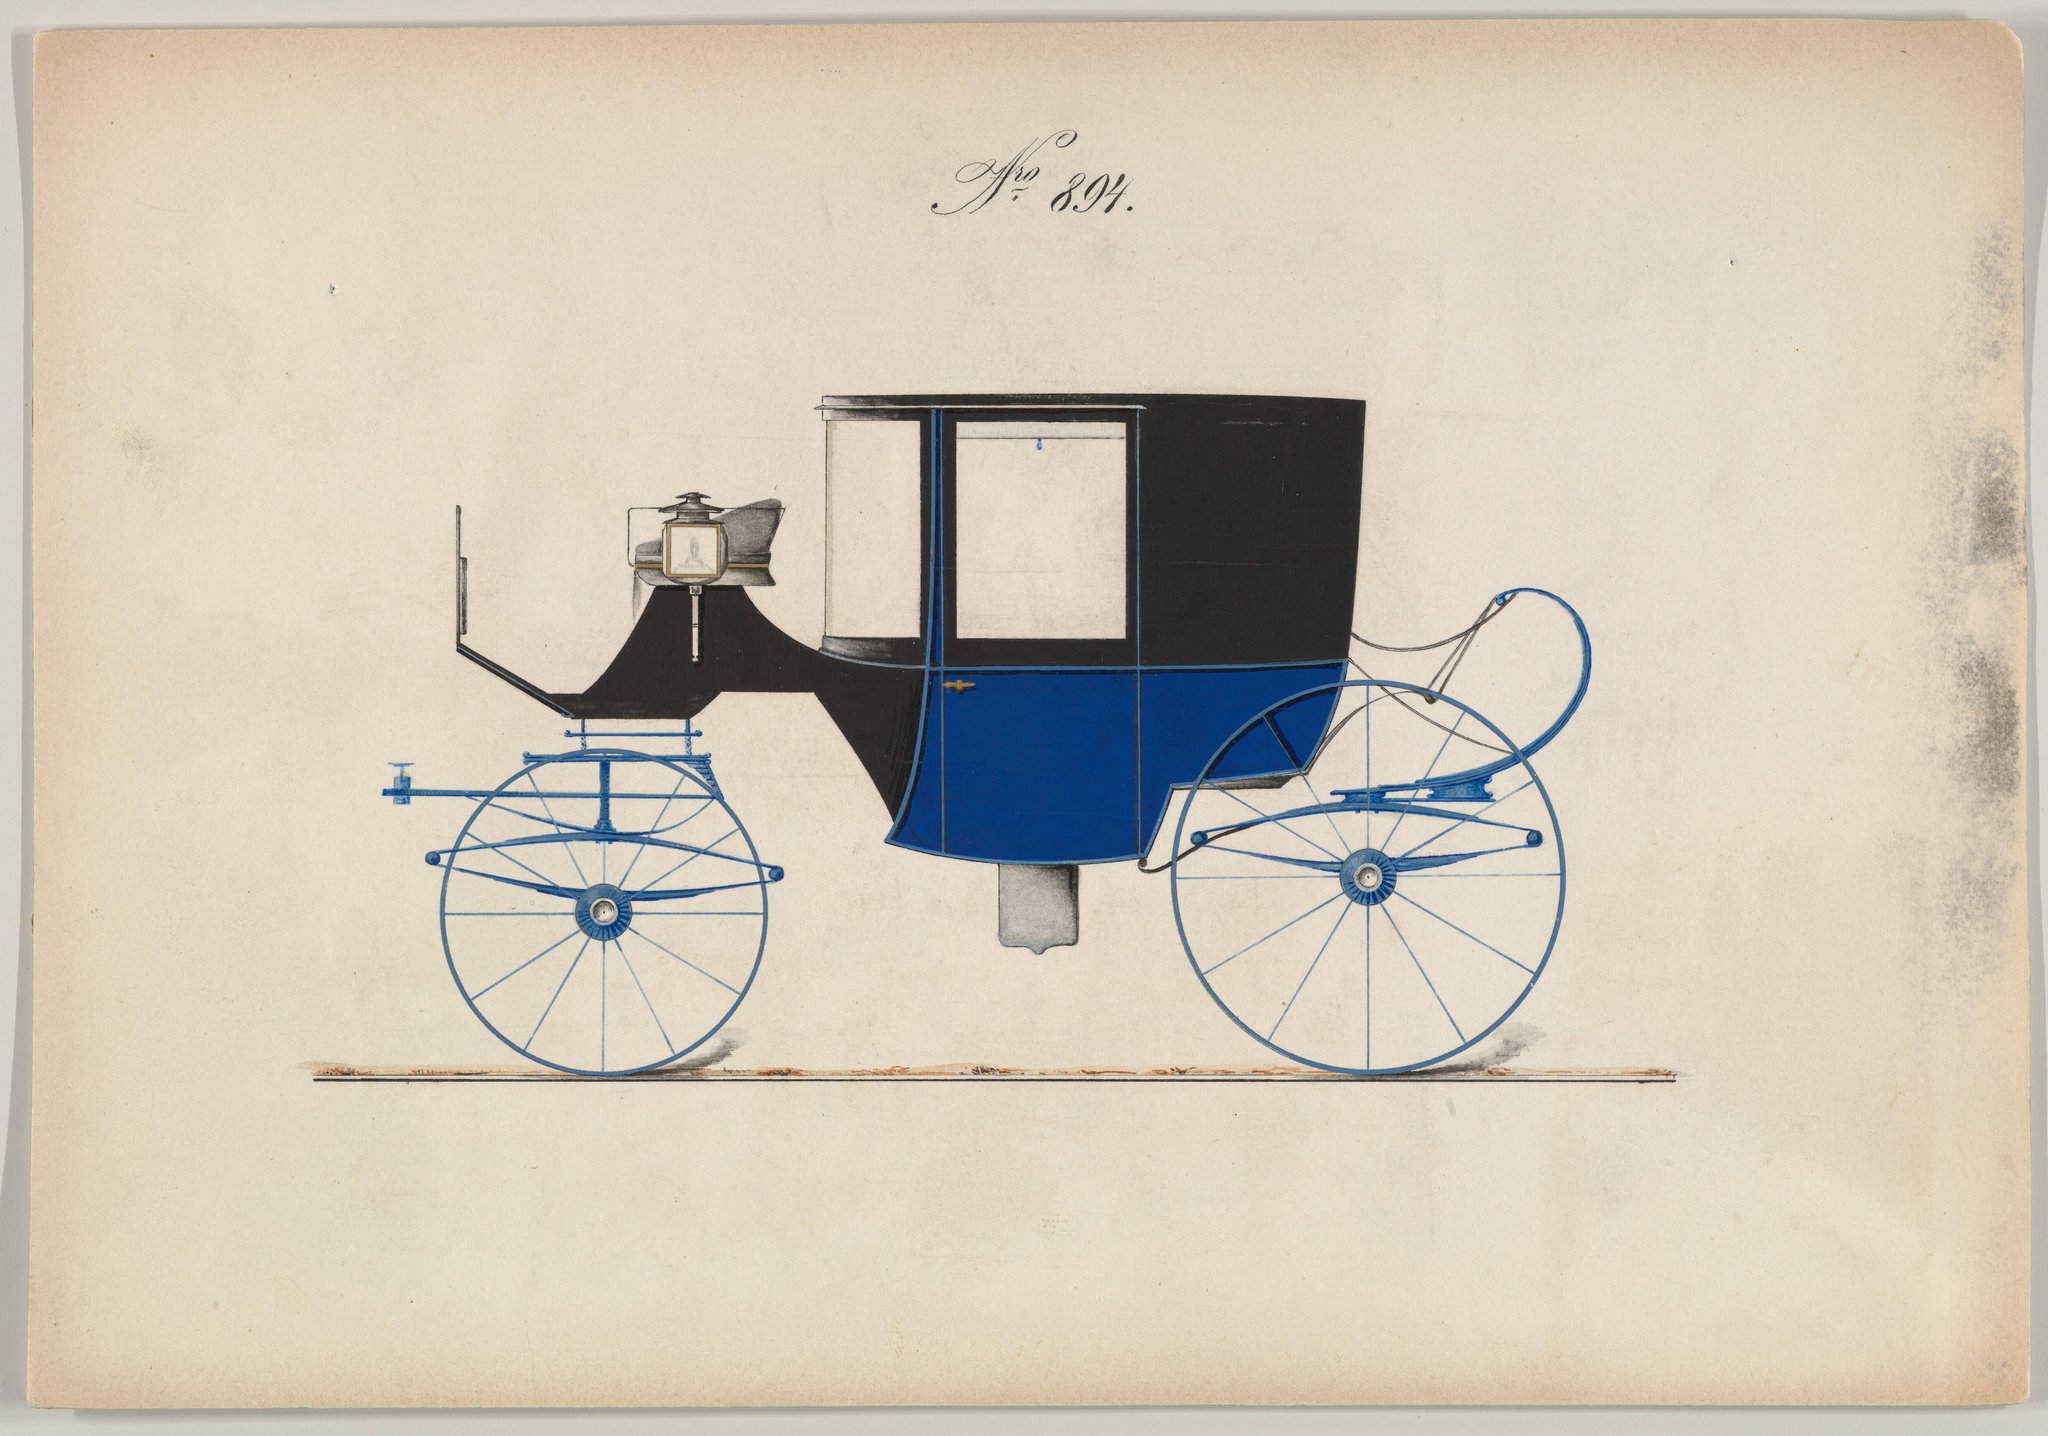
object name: drawing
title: Clarence #894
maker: brewster & co.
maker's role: manufacturer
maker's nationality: american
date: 1850-1870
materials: gouache, gum arabic, ink, watercolor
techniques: pen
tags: carriages